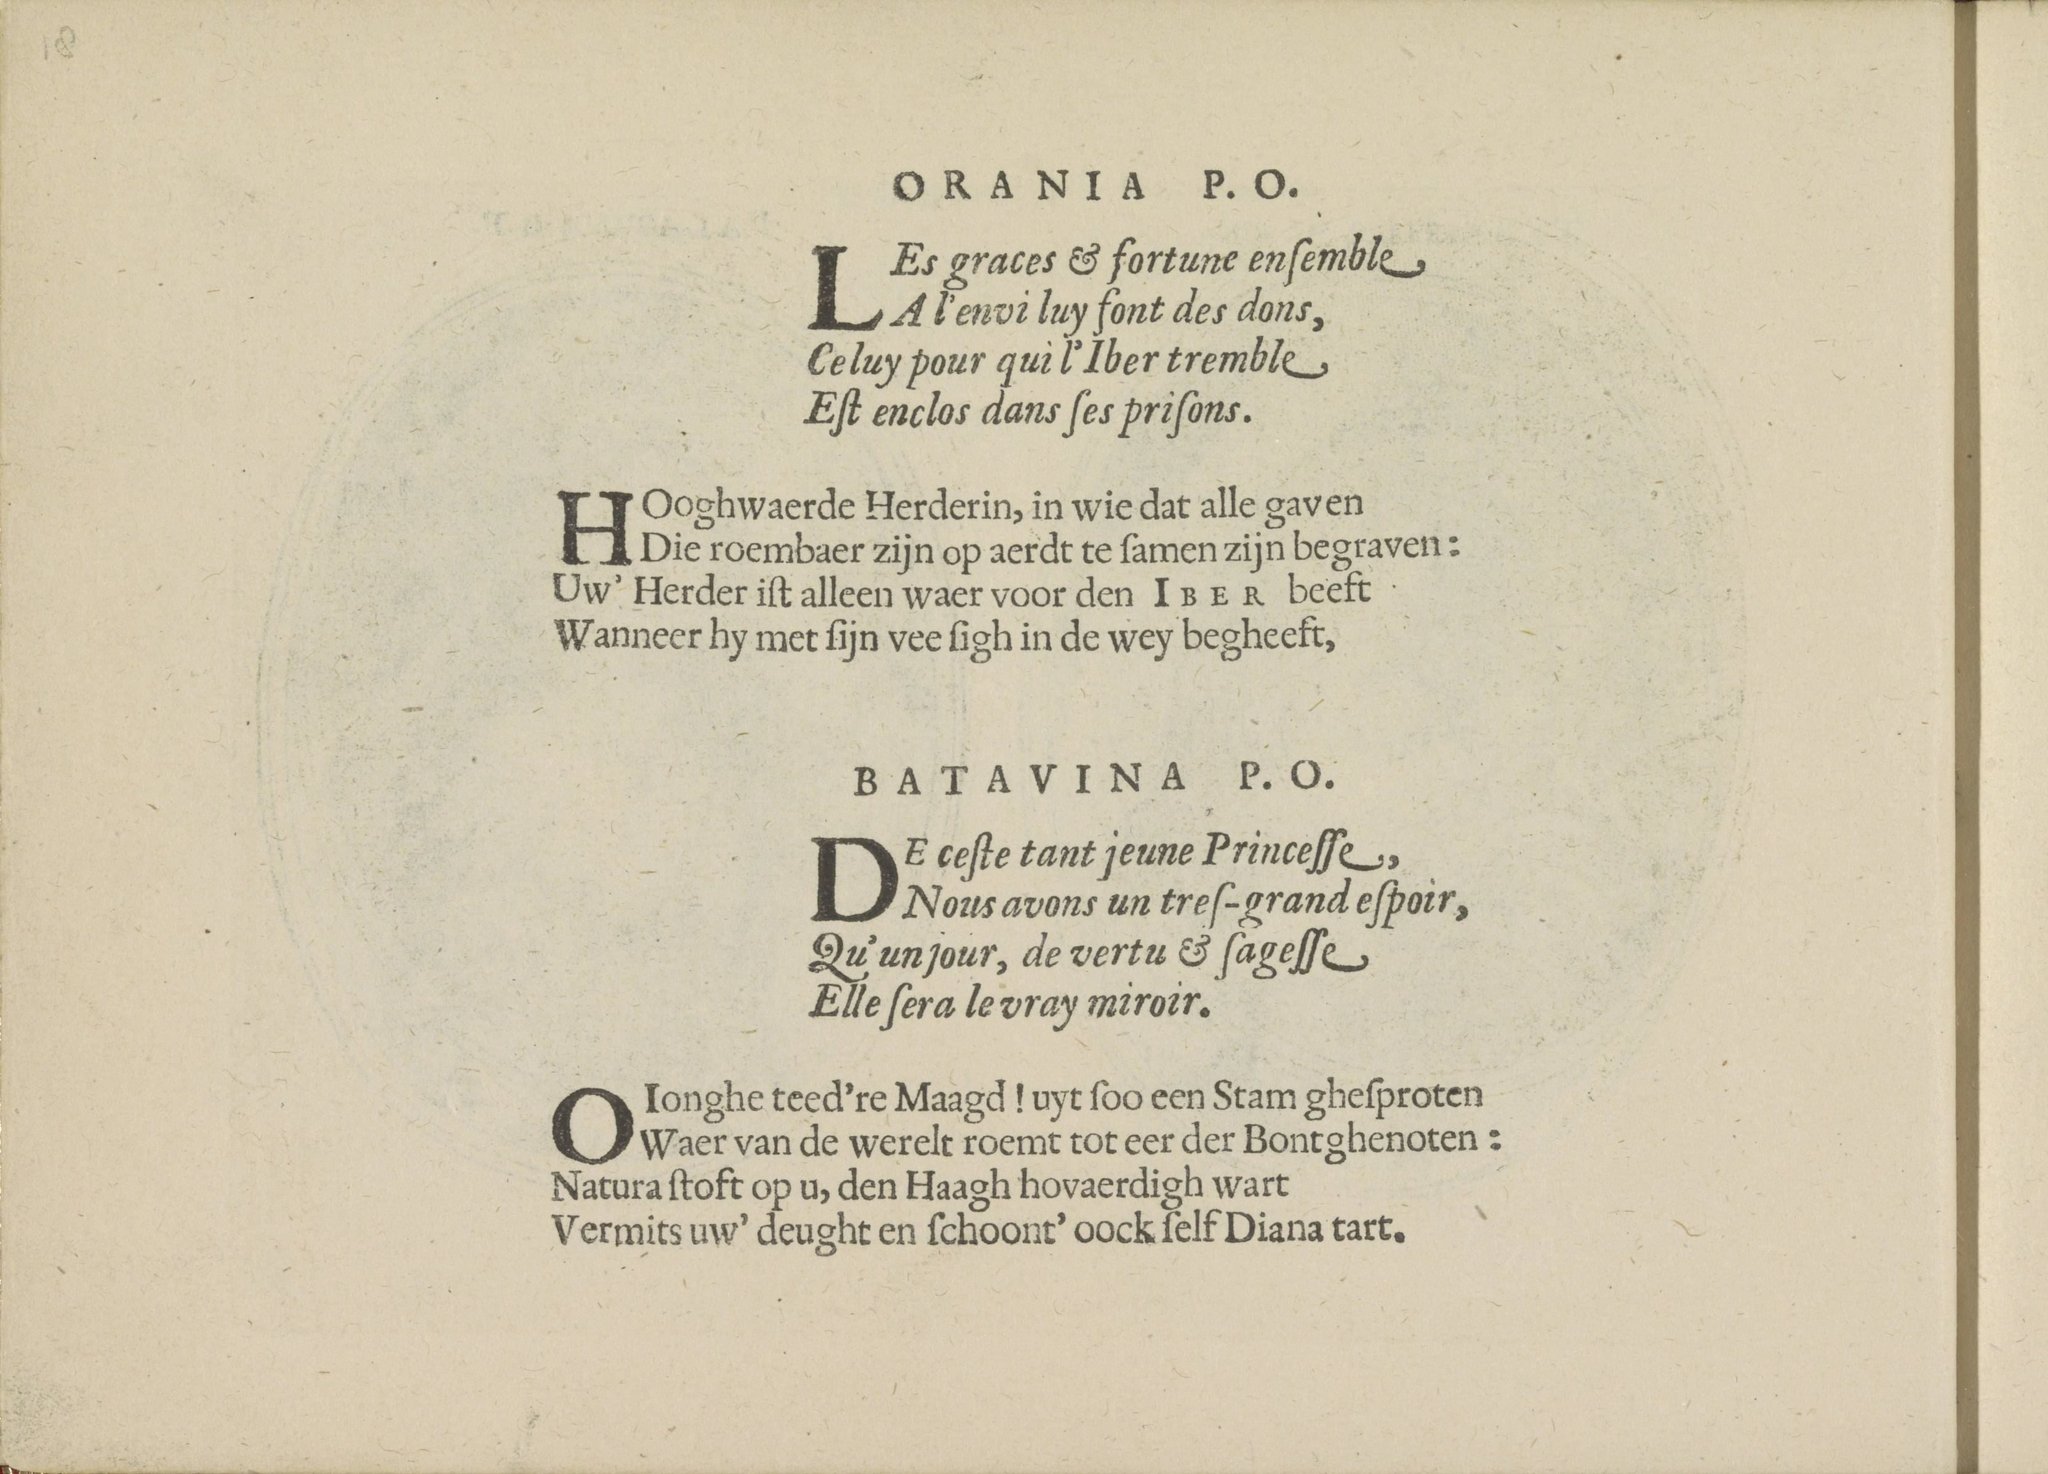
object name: album leaf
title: Les vrais pourtraits de quelques unes des plus grandes dames de la chrestiente desguisees en bergeres.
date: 1640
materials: paper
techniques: letterpress printing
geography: amsterdam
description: Twee keer twee kwatrijnen in het Frans en Nederlands bij de voorstellingen van Orania P.O. en Batavina P.O. Het blad maakt deel uit van een album.